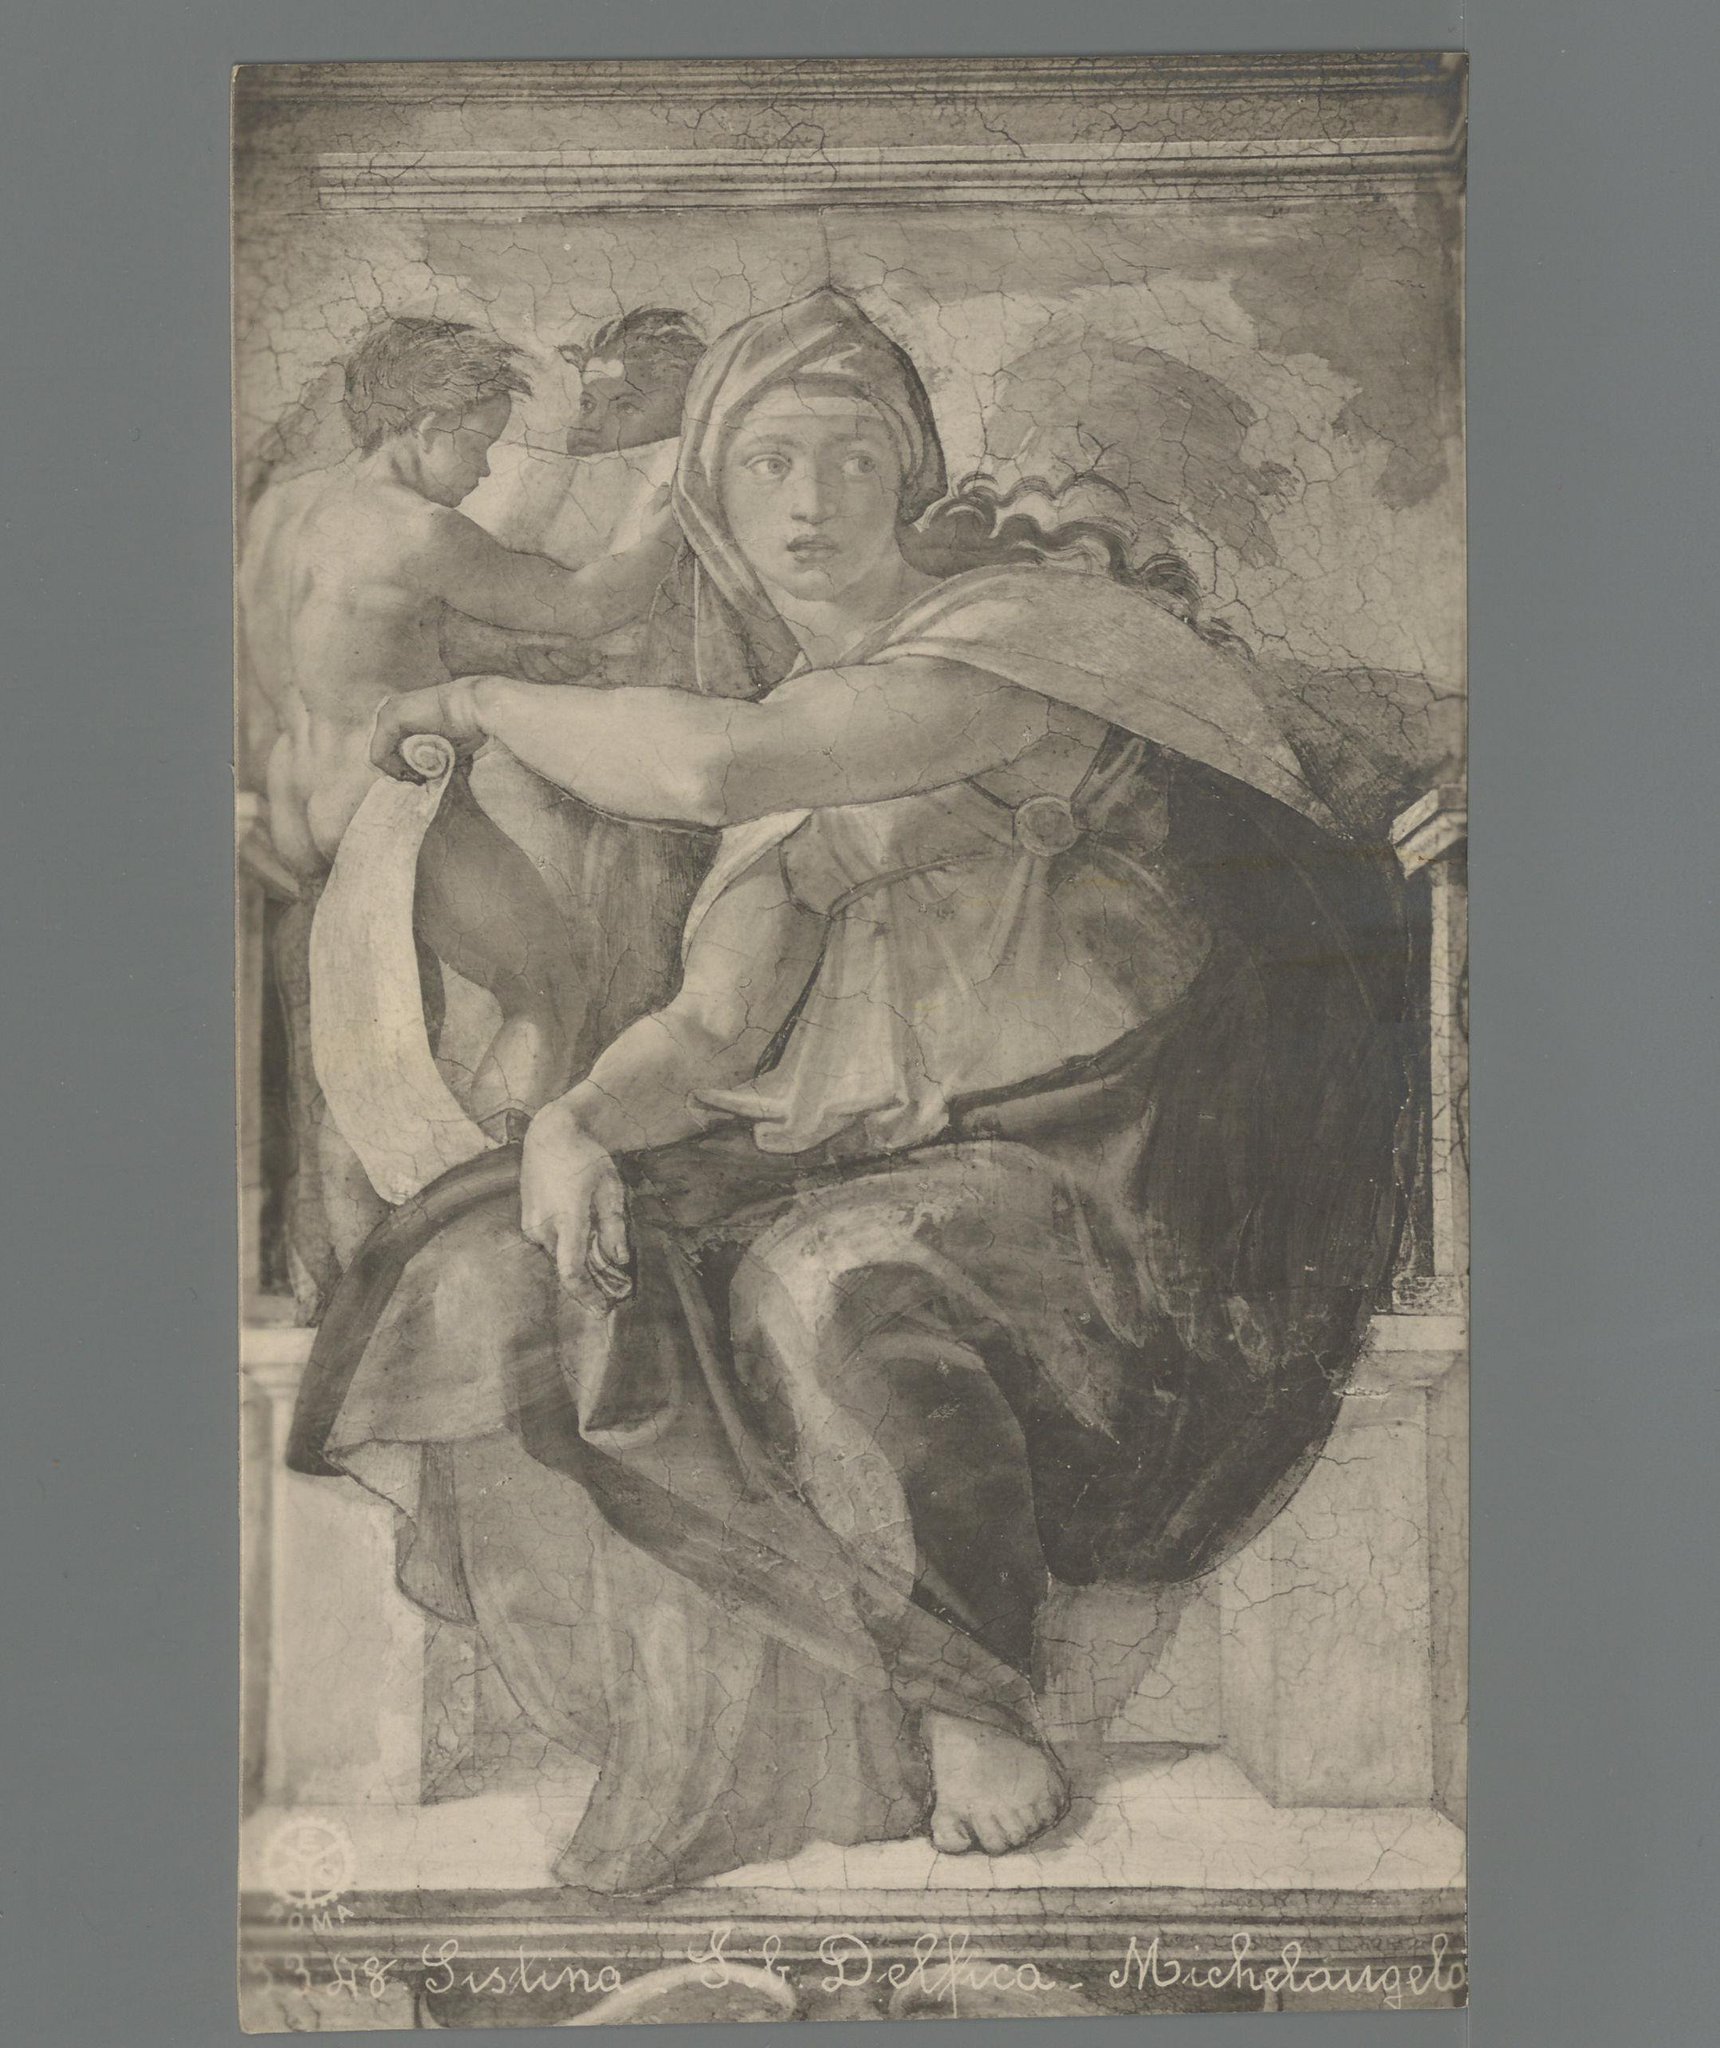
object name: photograph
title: Sistina. Sib. Delfica. Michelangelo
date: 1906-1930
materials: photographic support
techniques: photography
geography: rome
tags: sibyls (with name)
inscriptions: collector's mark: ‘AFE v S’